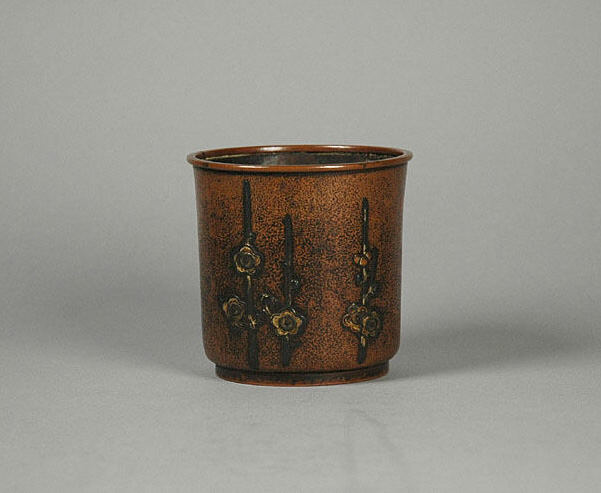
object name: incense burner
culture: japanese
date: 1701-1800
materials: bronze